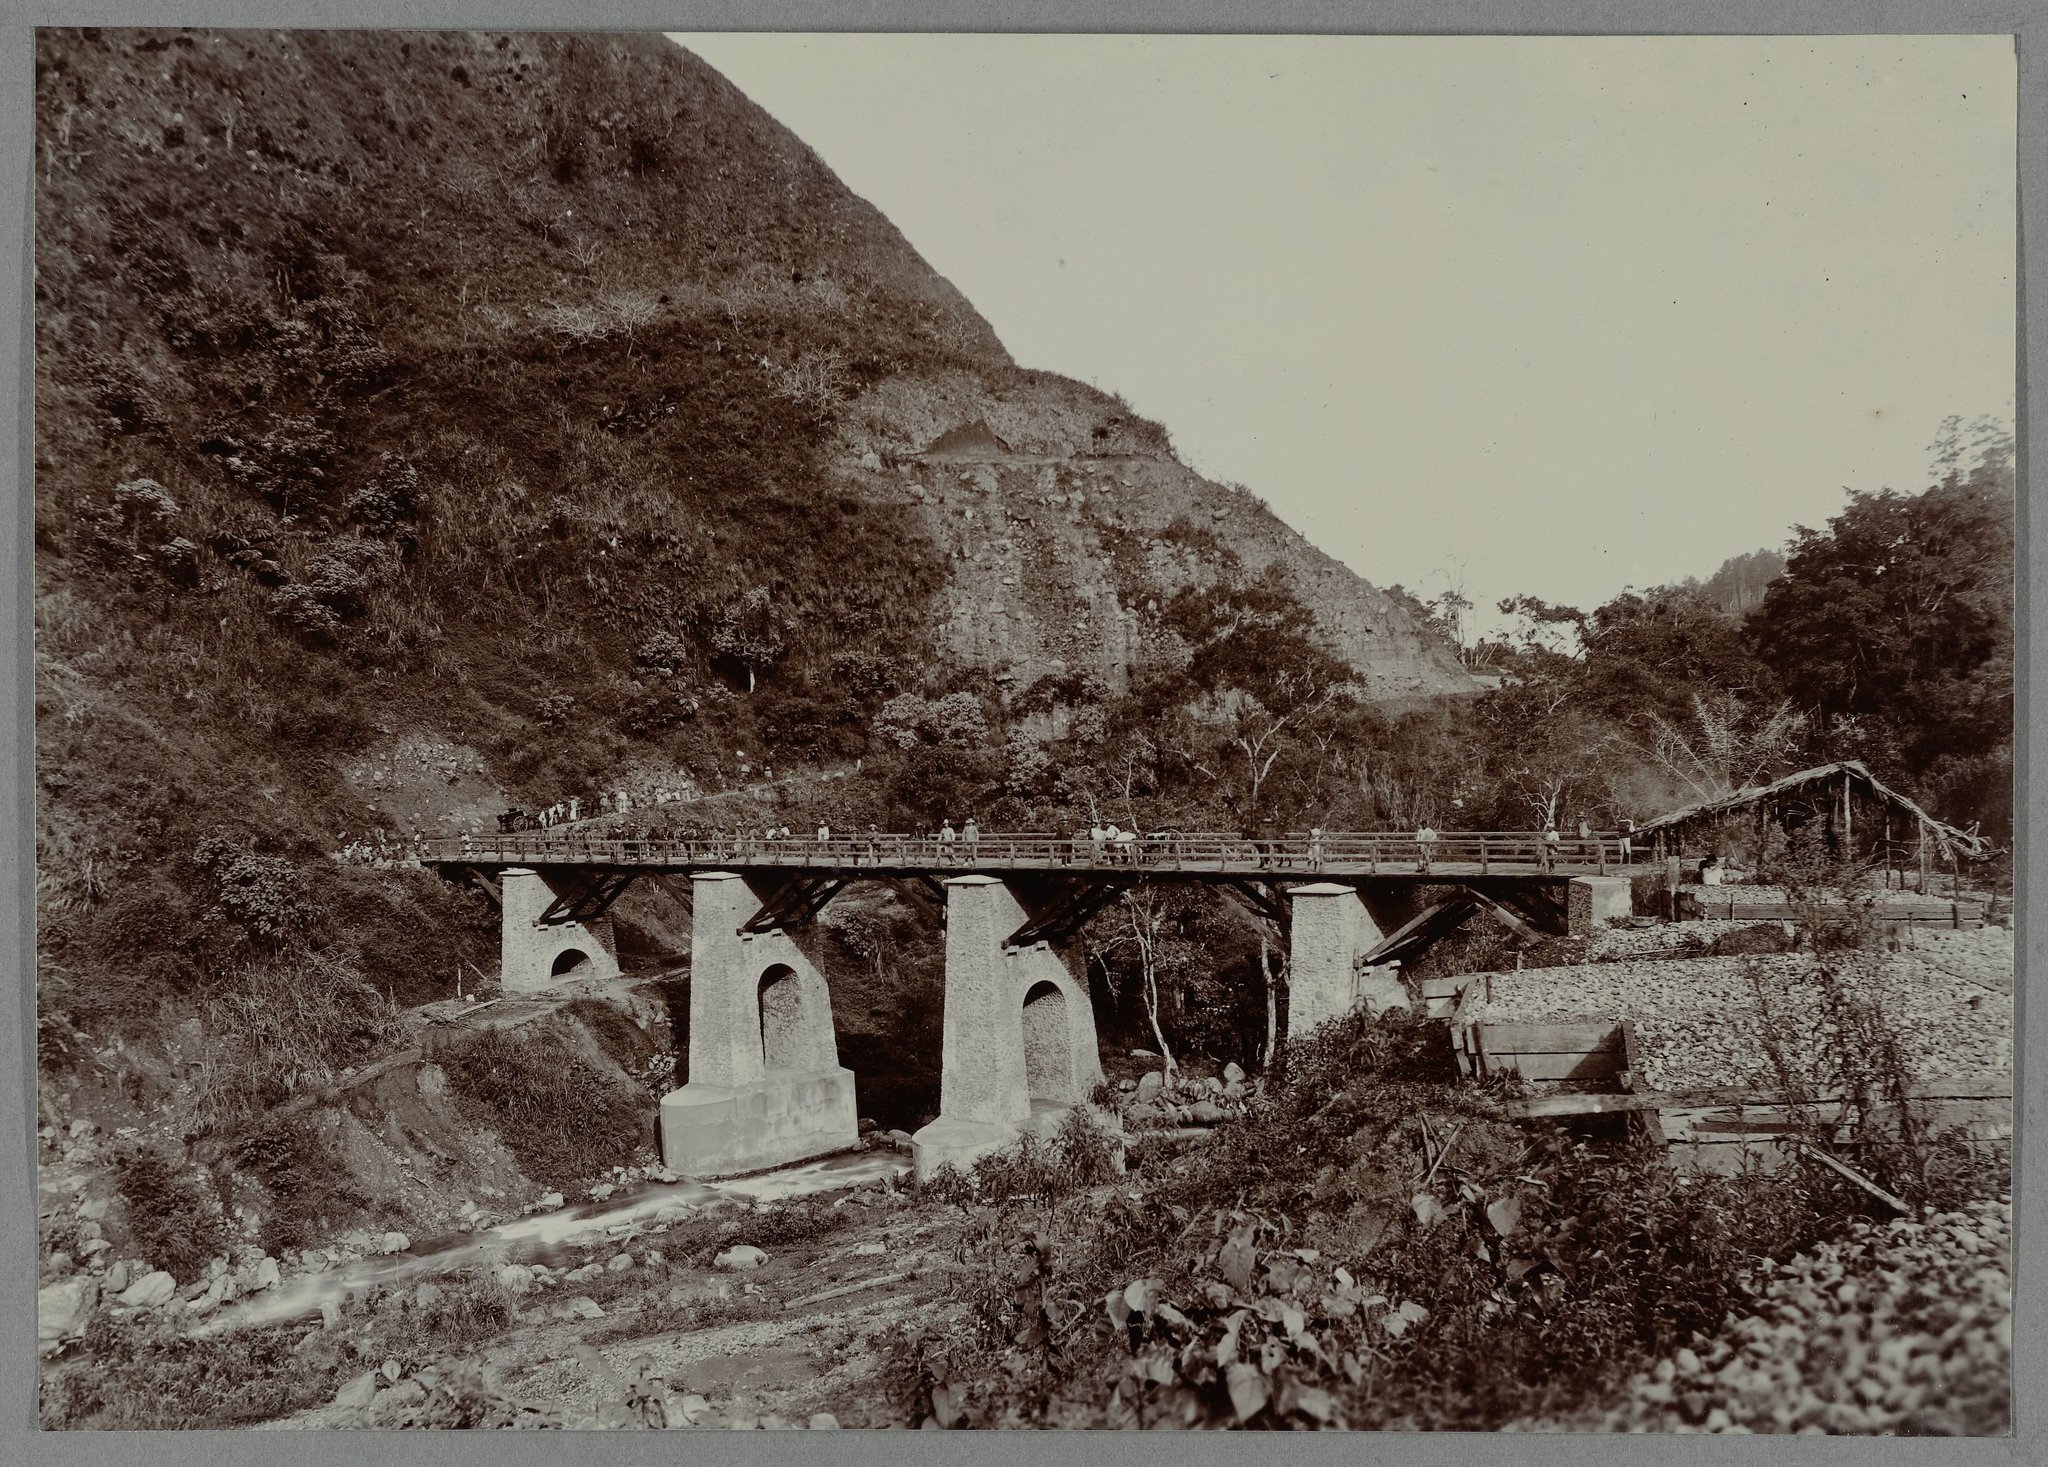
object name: photograph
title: Brug over de Woih ni Enang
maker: Anonymous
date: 1911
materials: photographic support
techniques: photography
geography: north sumatra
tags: albertus dominicus laman trip, building activities, traffic by road or path with motor-vehicle, landscapes in tropical and sub-tropical regions, road, path, bridge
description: Na de expedities naar de Gajo- en Alaslanden o.l.v. Van Daalen (eerste tocht in 1901), werd hij in 1903 belast met voorbereiding van permanente vestiging van Nederlands gezag. Aanleg van een weg van de Noordkust naar het binnenland was hierbij van groot belang. Deze zgn. Gajoweg werd aangelegd tussen 1903 en 1914, van Bireuen aan de kust naar Takinguen aan het bergmeer Danau Lauttawar, totale lente 104 km.